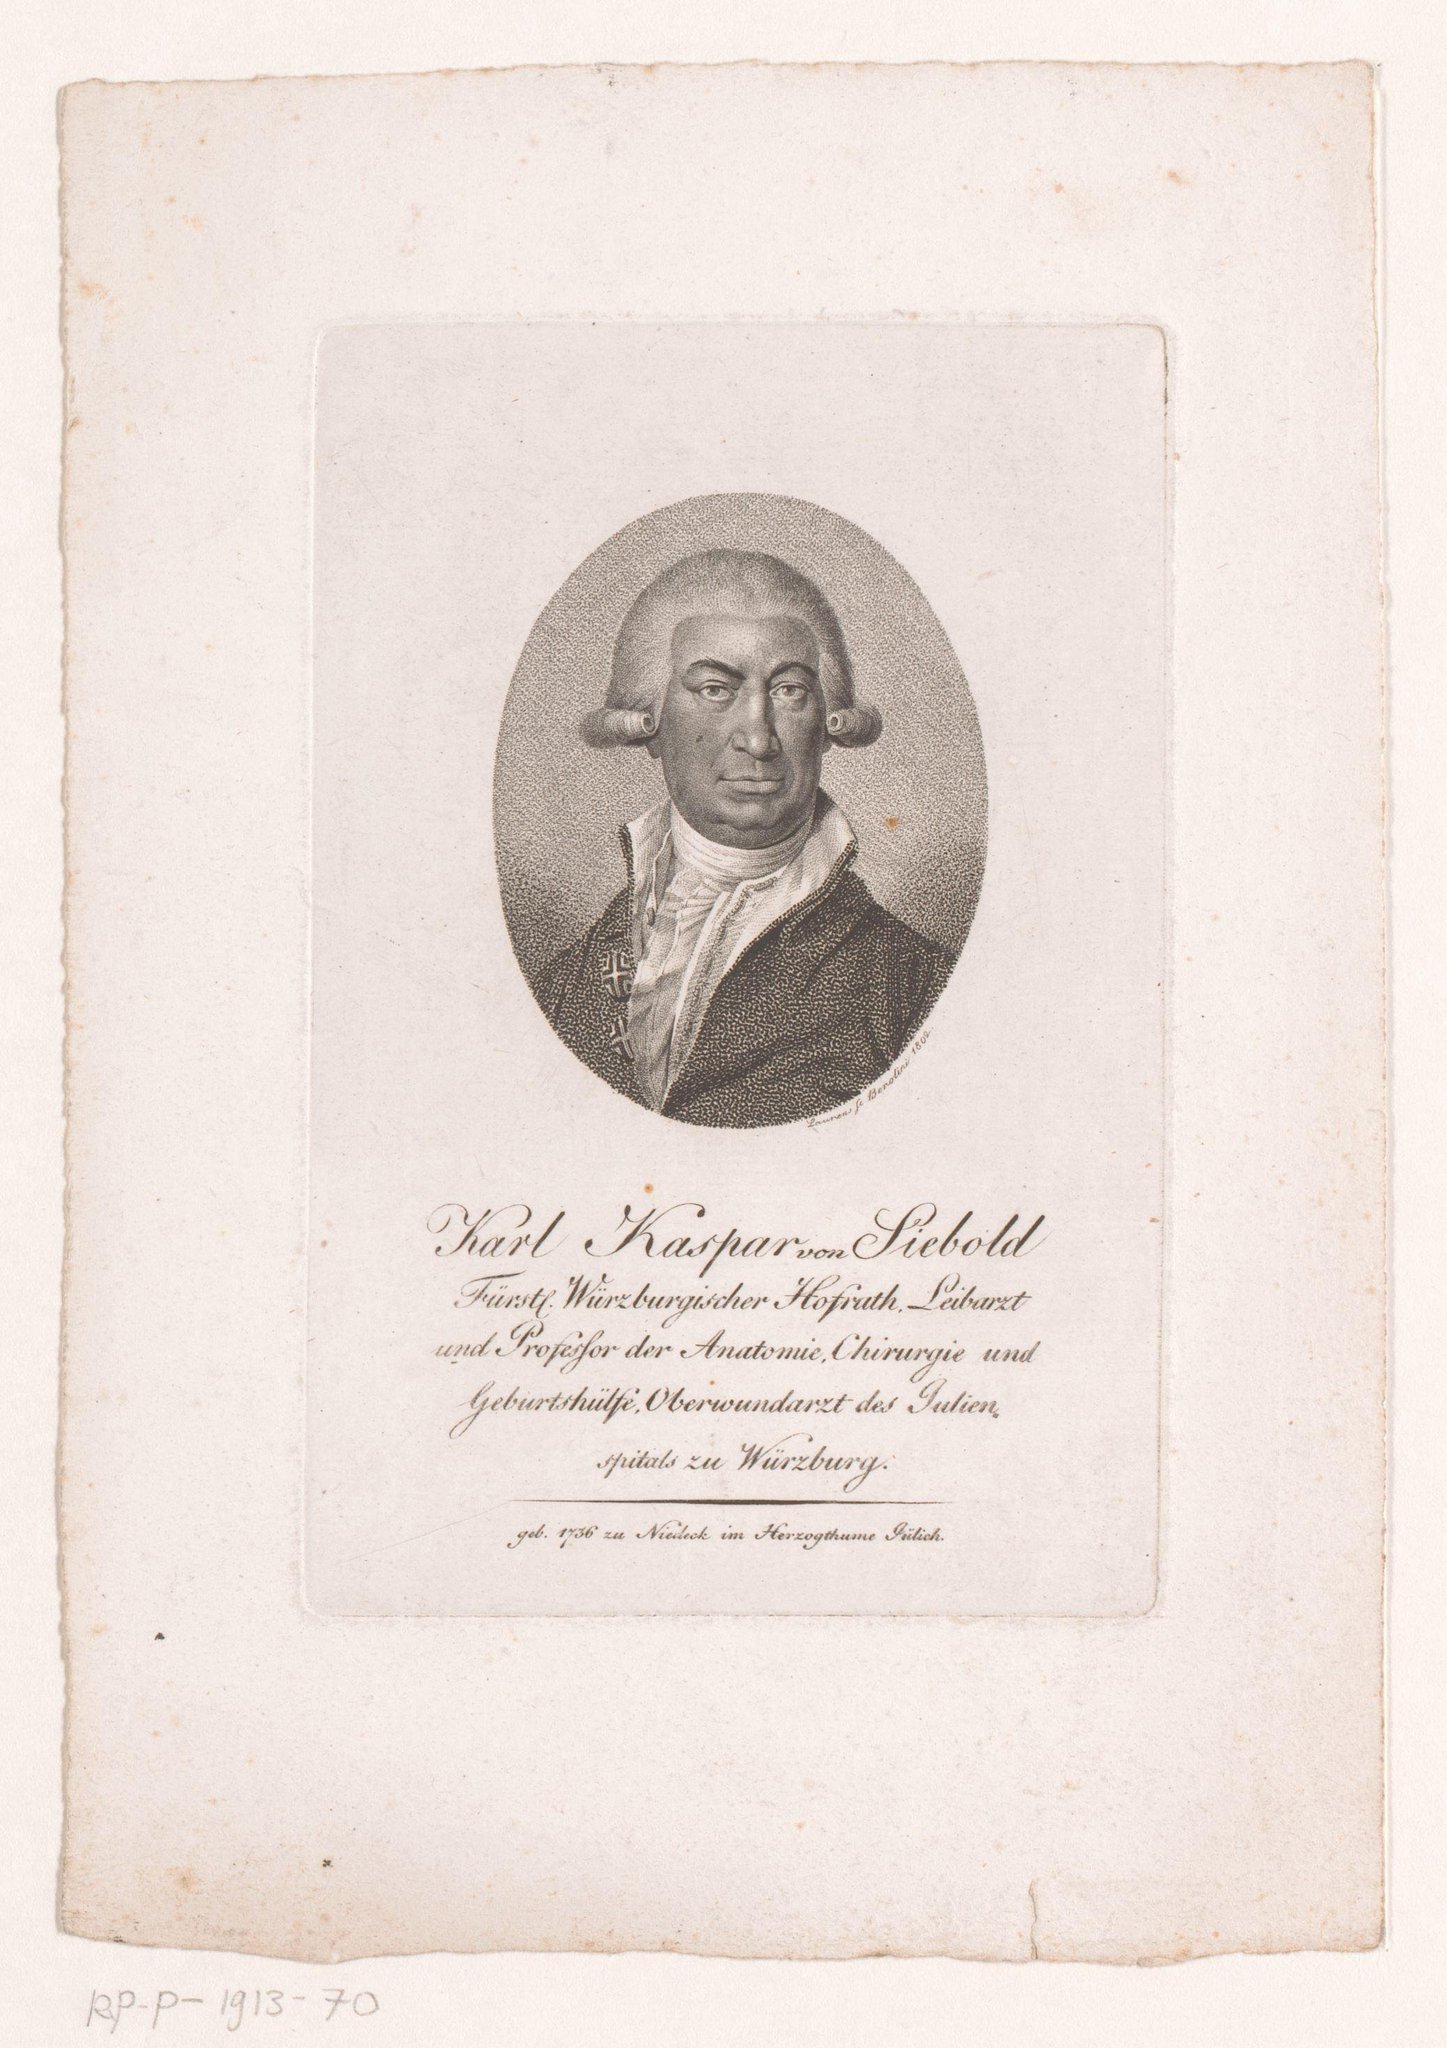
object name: print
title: Portret van Karl Kaspar von Siebold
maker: johann daniel laurenz (ii)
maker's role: draughtsman, print maker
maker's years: 1770-1832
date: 1802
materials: paper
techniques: stippling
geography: berlin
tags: historical persons, physician, doctor (+ portrait of scholar, scientist)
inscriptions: collector's mark: Lugt 2228